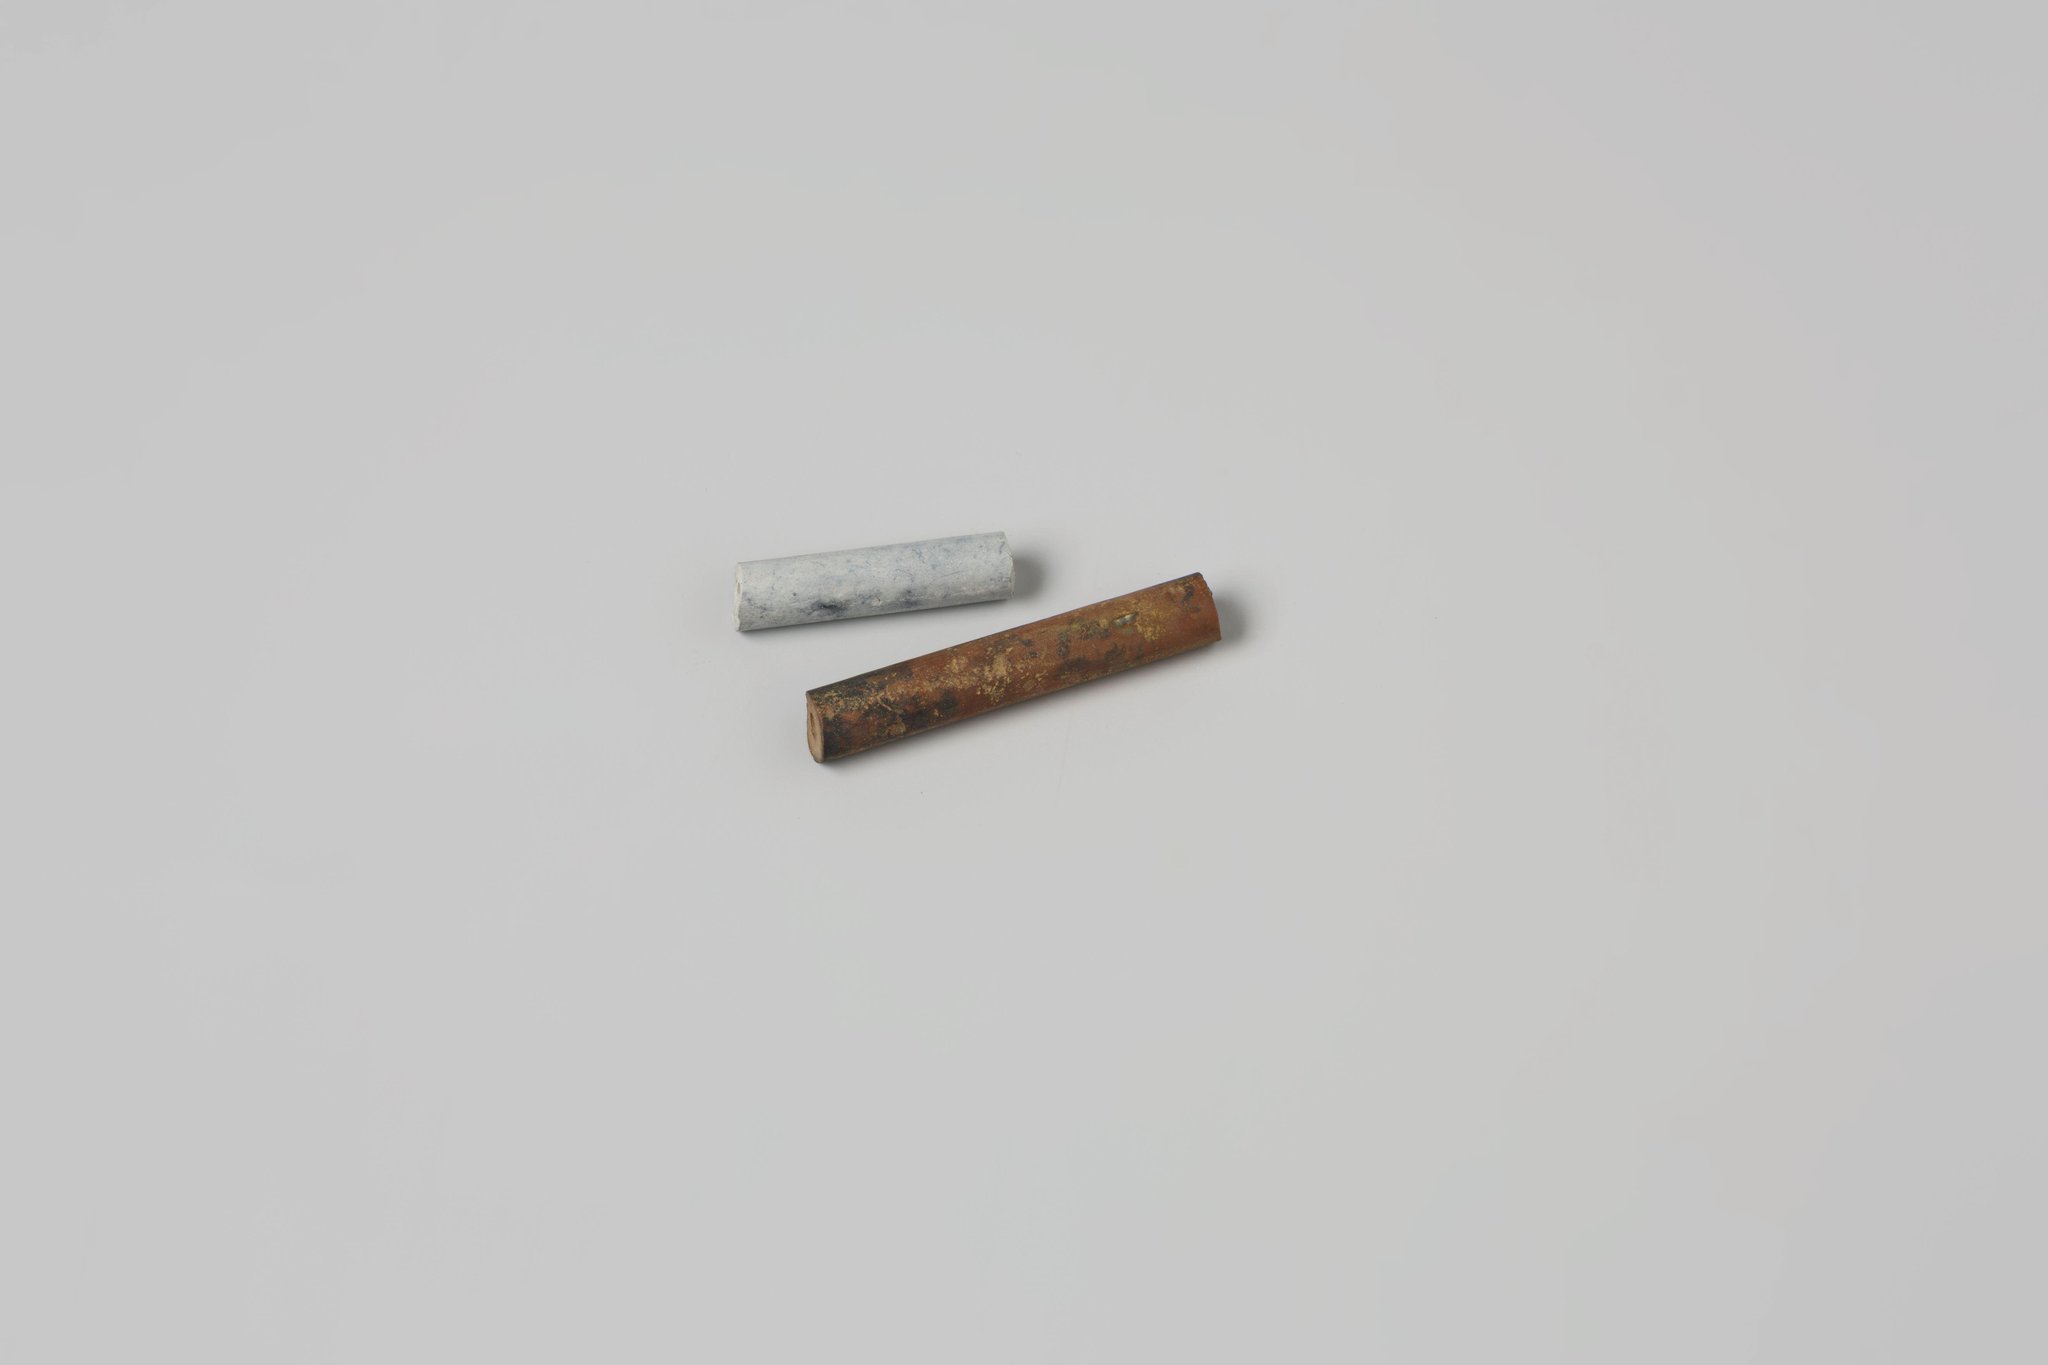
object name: pipe stem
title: Fragment van een pijpensteel uit het wrak van de Oost-Indiëvaarder 't Vliegend Hart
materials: clay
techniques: firing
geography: gouda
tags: 't vliegend hart (schip), verenigde oostindische compagnie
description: Twee fragmenten van stelen van aarden Goudse pijpen met blauwe en bruine aanslag. Fragments of bowls and stems.